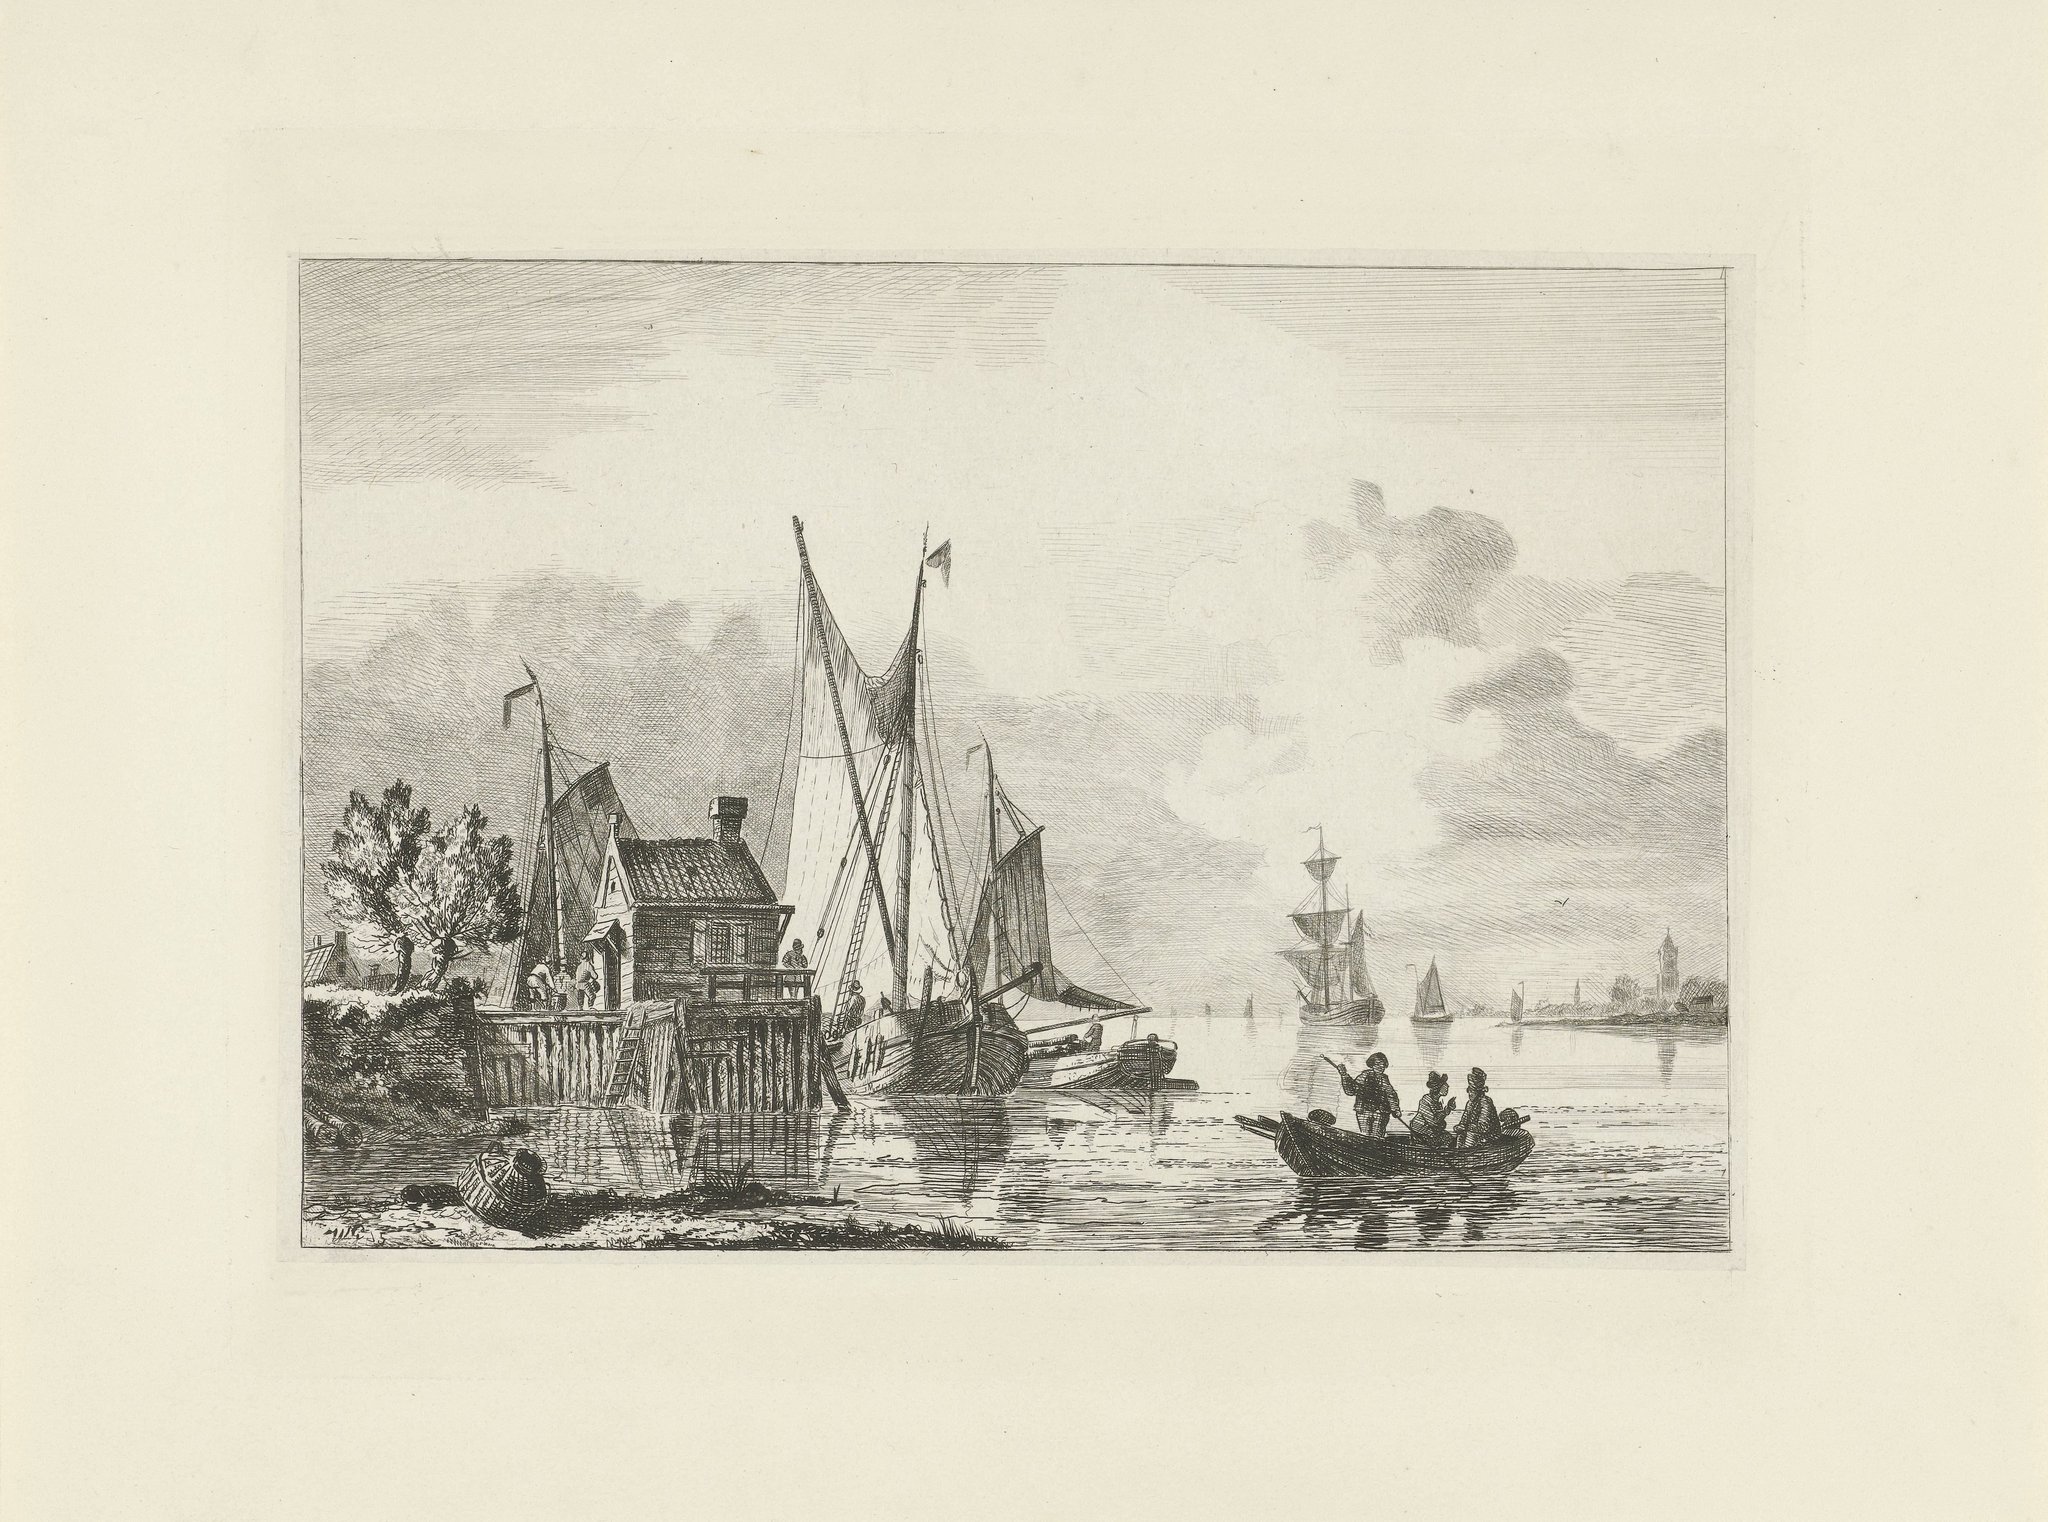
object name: print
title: Riviergezicht met aangemeerde zeilschepen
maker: willem gruyter jr.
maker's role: draughtsman, print maker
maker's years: 1817-1880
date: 1832-1880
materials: paper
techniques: etching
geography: amsterdam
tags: rowing-boat, canoe, etc., sailing-ship, sailing-boat (+ four persons or more ~ traffic and transport)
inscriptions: collector's mark: Lugt 2760, collector's mark: Lugt 2228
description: Houten huis bij een pier met aangemeerde zeilschepen en rechts op de voorgrond een roeiboot met drie mannen erin.